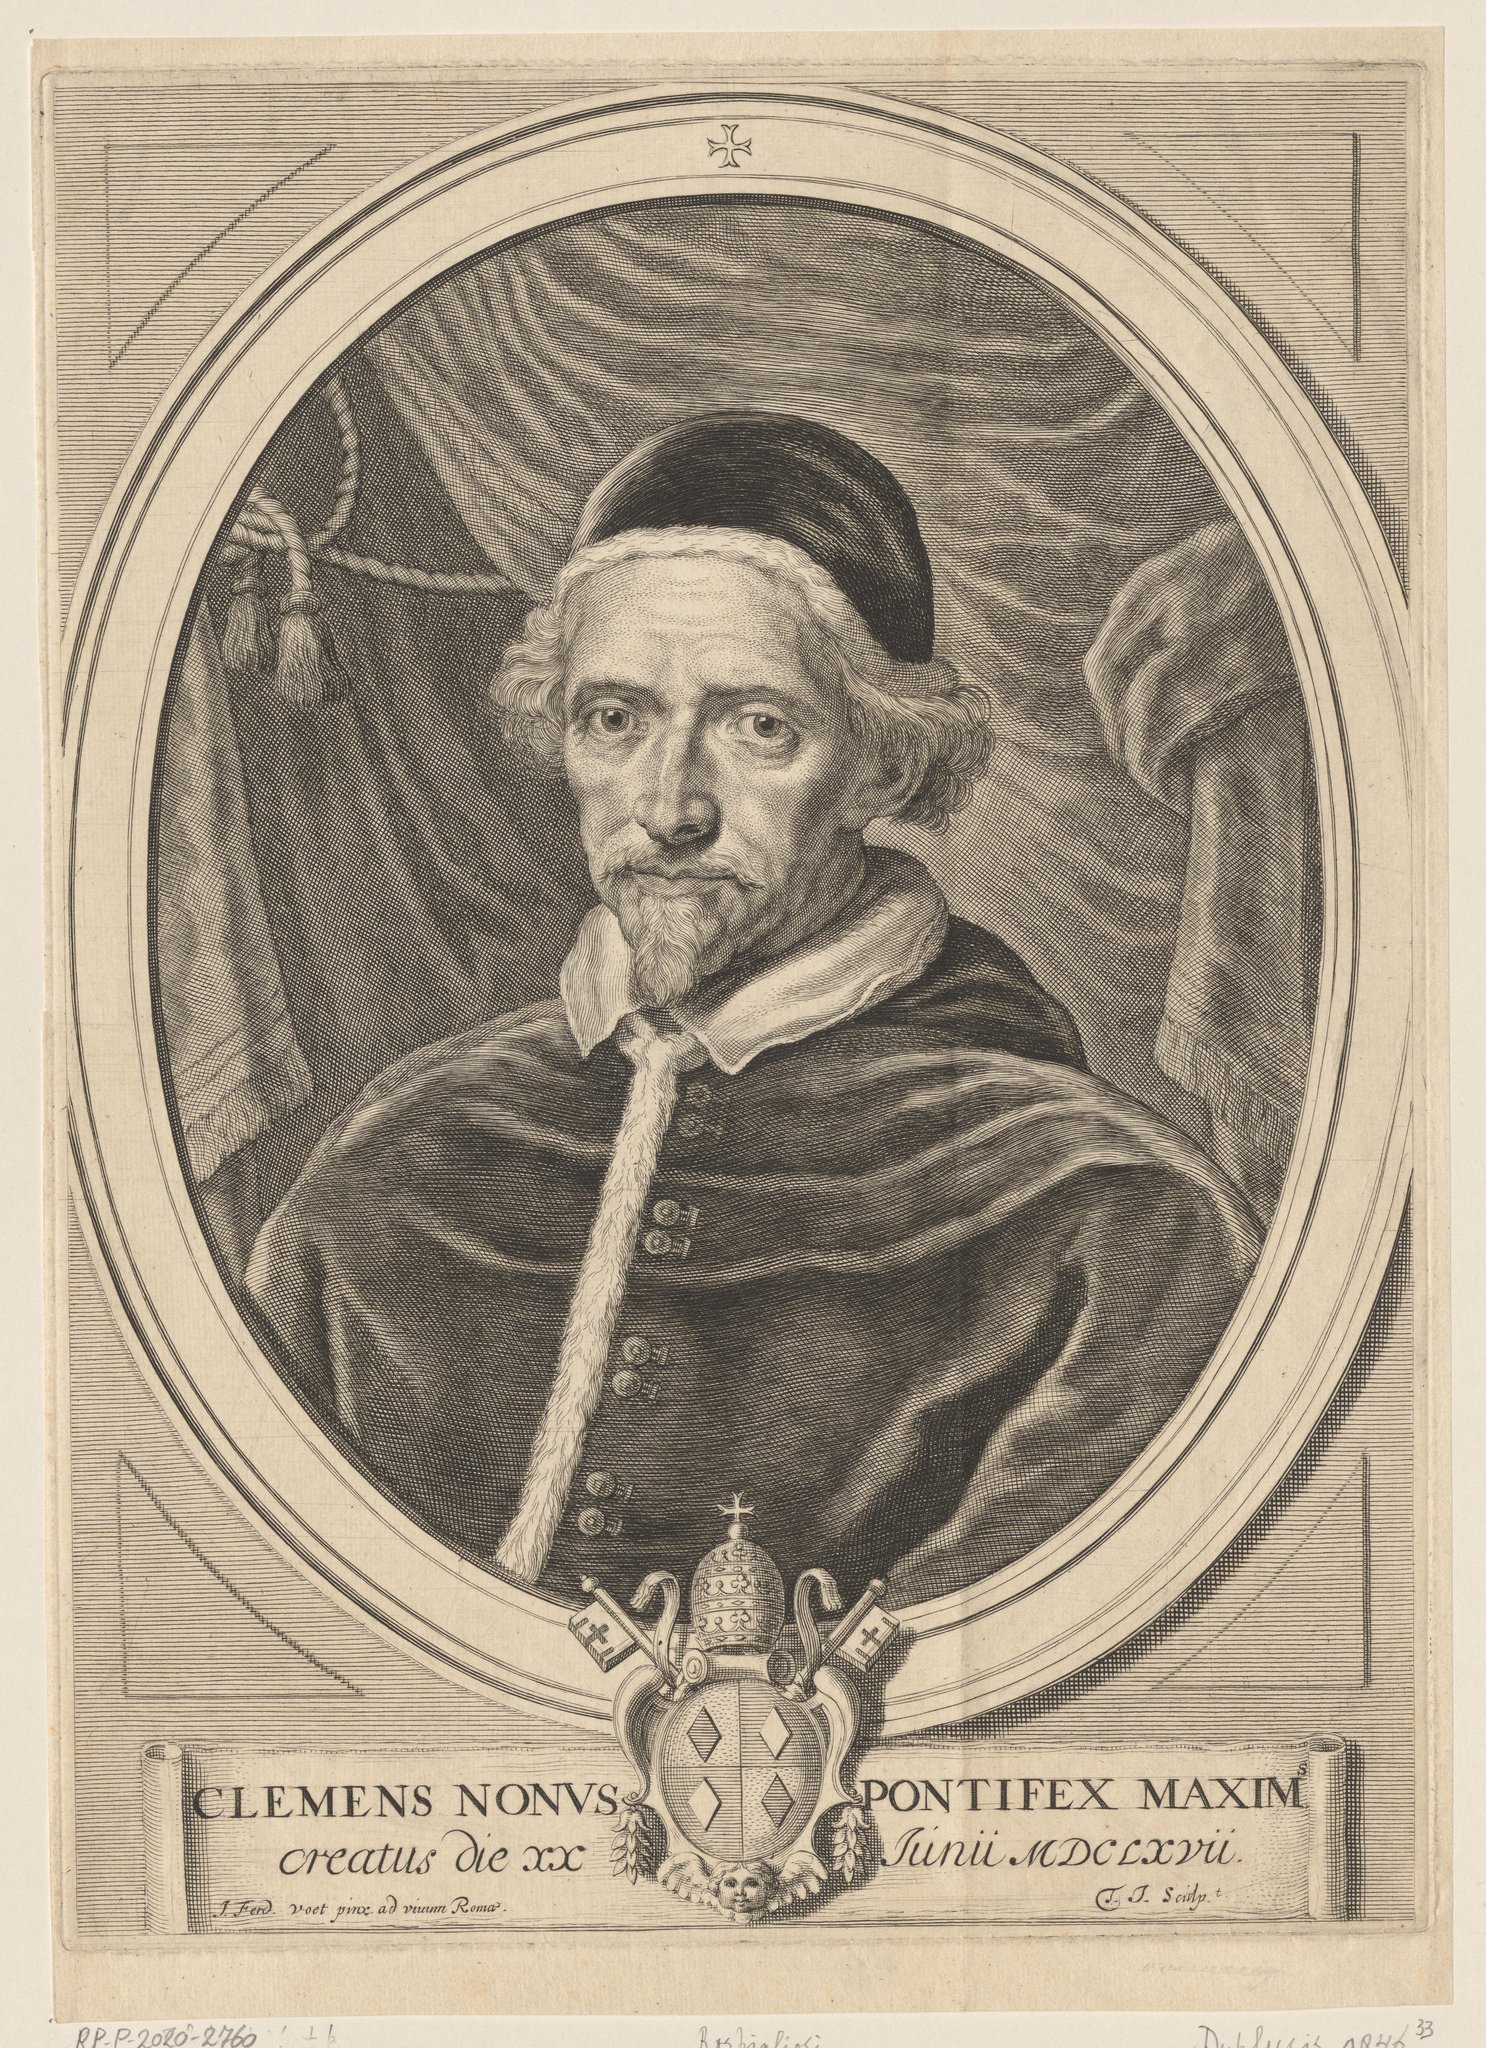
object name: print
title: Portret van paus Clemens IX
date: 1600-1649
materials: paper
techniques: engraving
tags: clemens ix, historical persons, pope